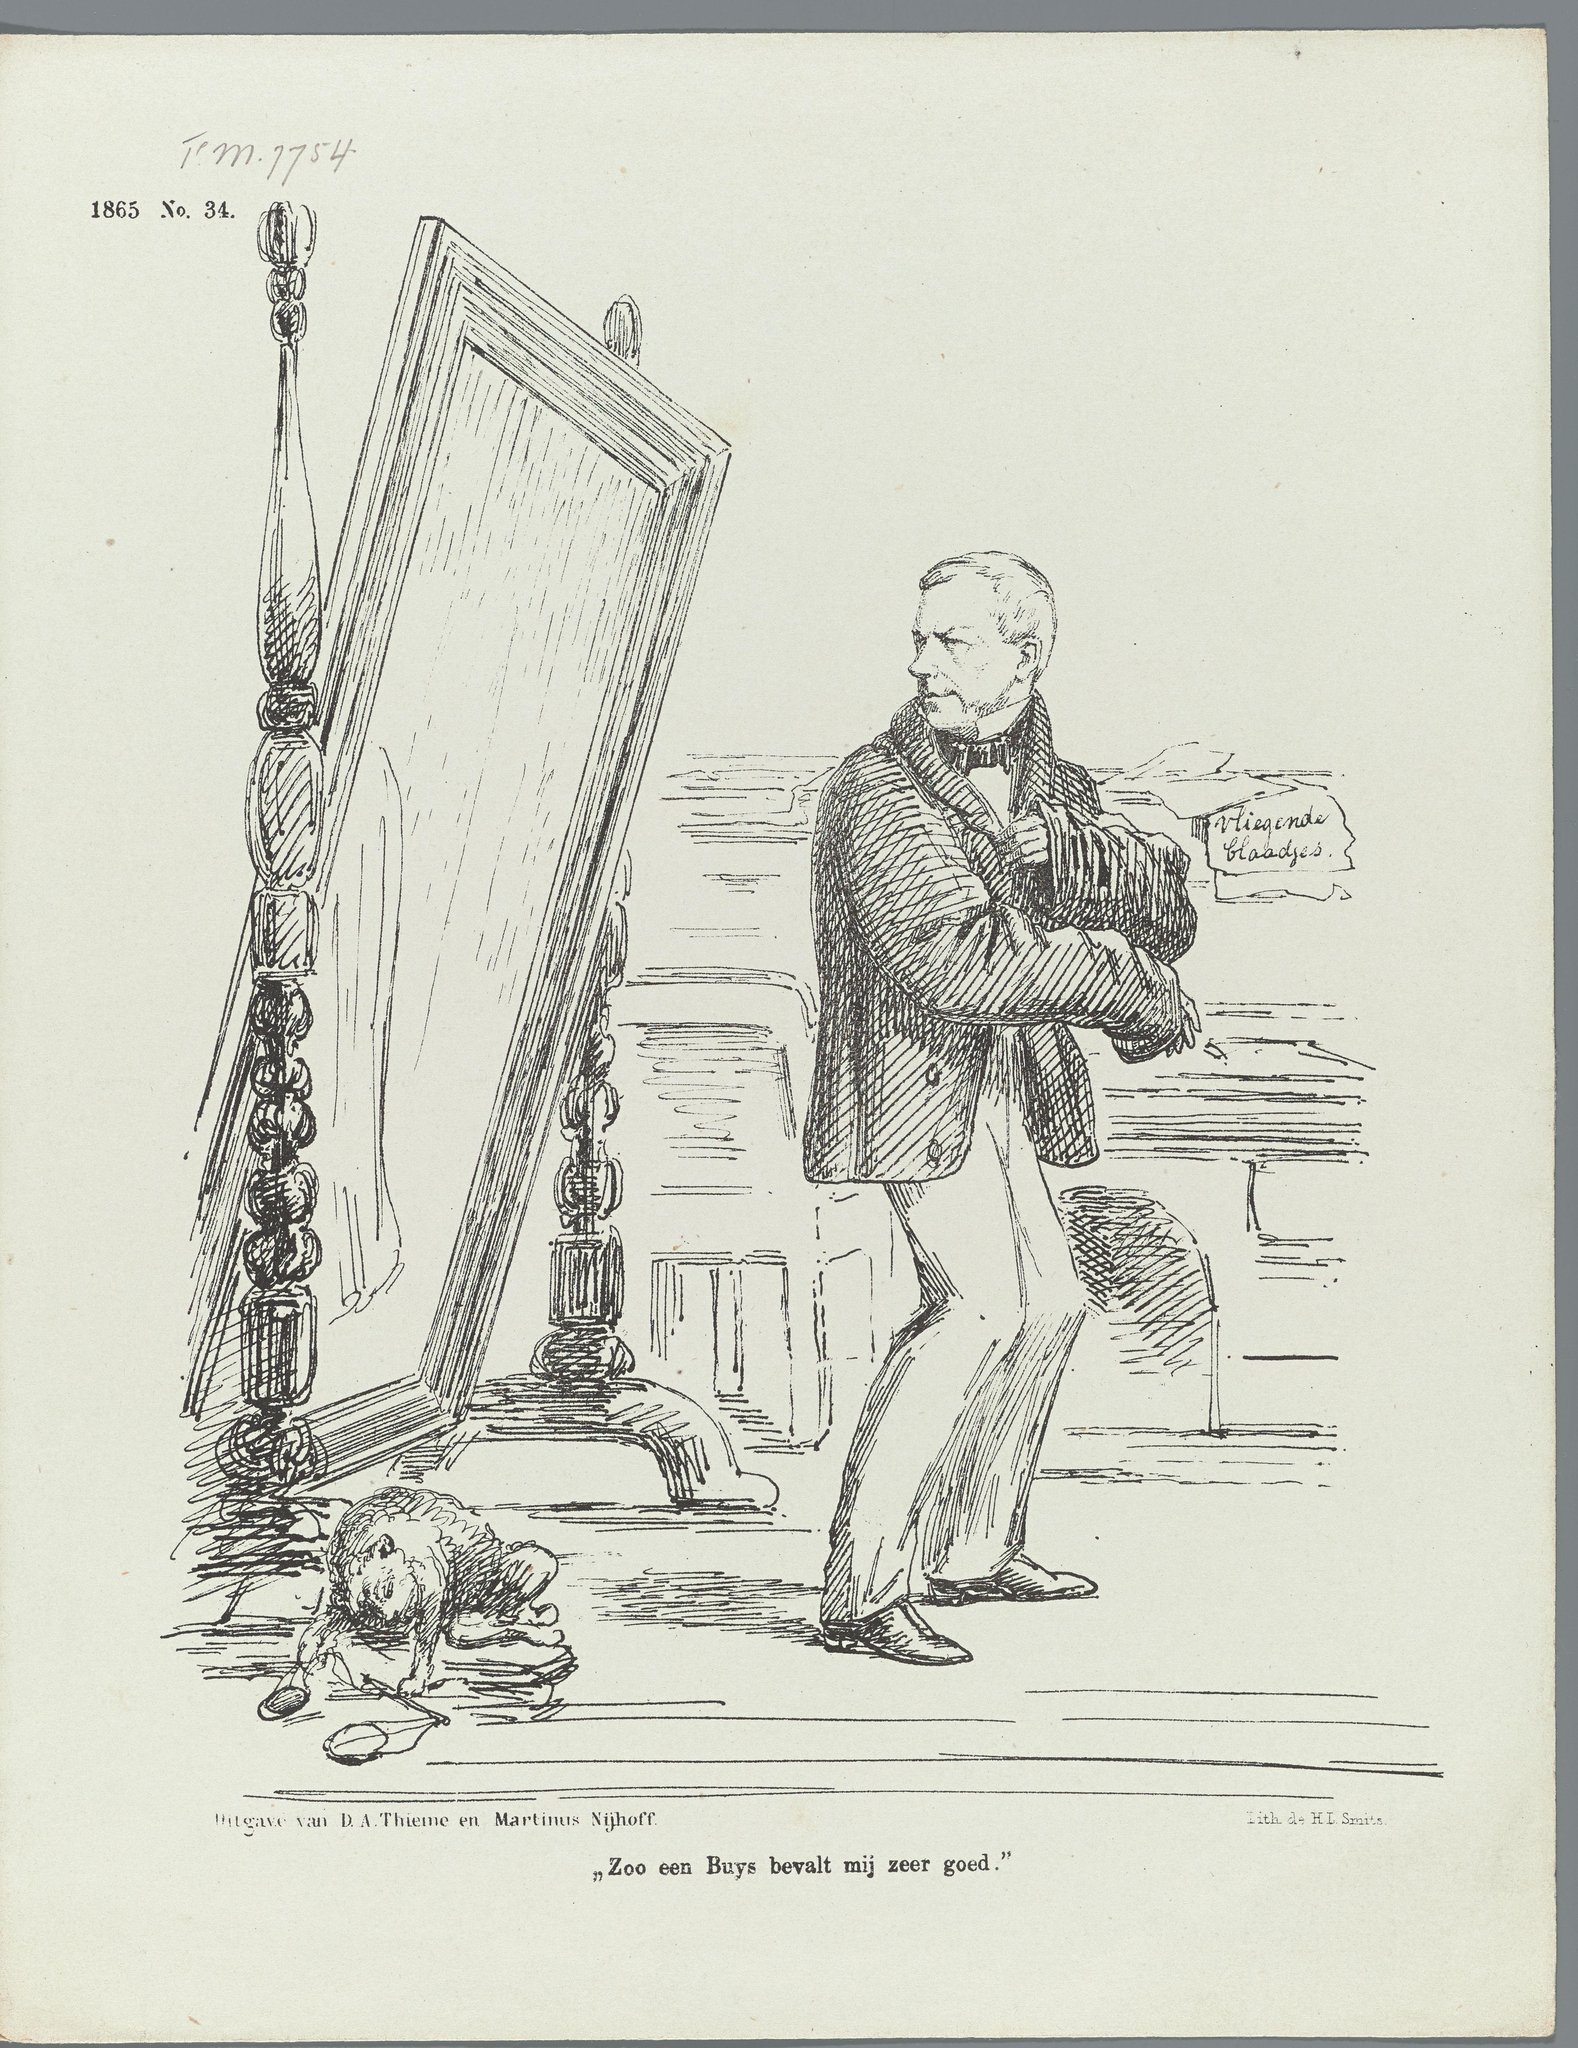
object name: cartoon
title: Spotprent op Groen van Prinsterer, 1865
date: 1865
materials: paper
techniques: lithograph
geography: netherlands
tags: guillaume groen van prinsterer, looking in the mirror; contemplation of own beauty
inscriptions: collector's mark: Lugt 2228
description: Spotprent op Groen van Prinsterer die trots na de jegens hem positieve artikel geschreven door Prof. Buys in de Gids. Groen van Prinsterer een nieuw jasje passend in de spiegel. Plaat verschenen bij het weekblad De Nederlandsche Spectator, nr. 34, 26 augustus1865.